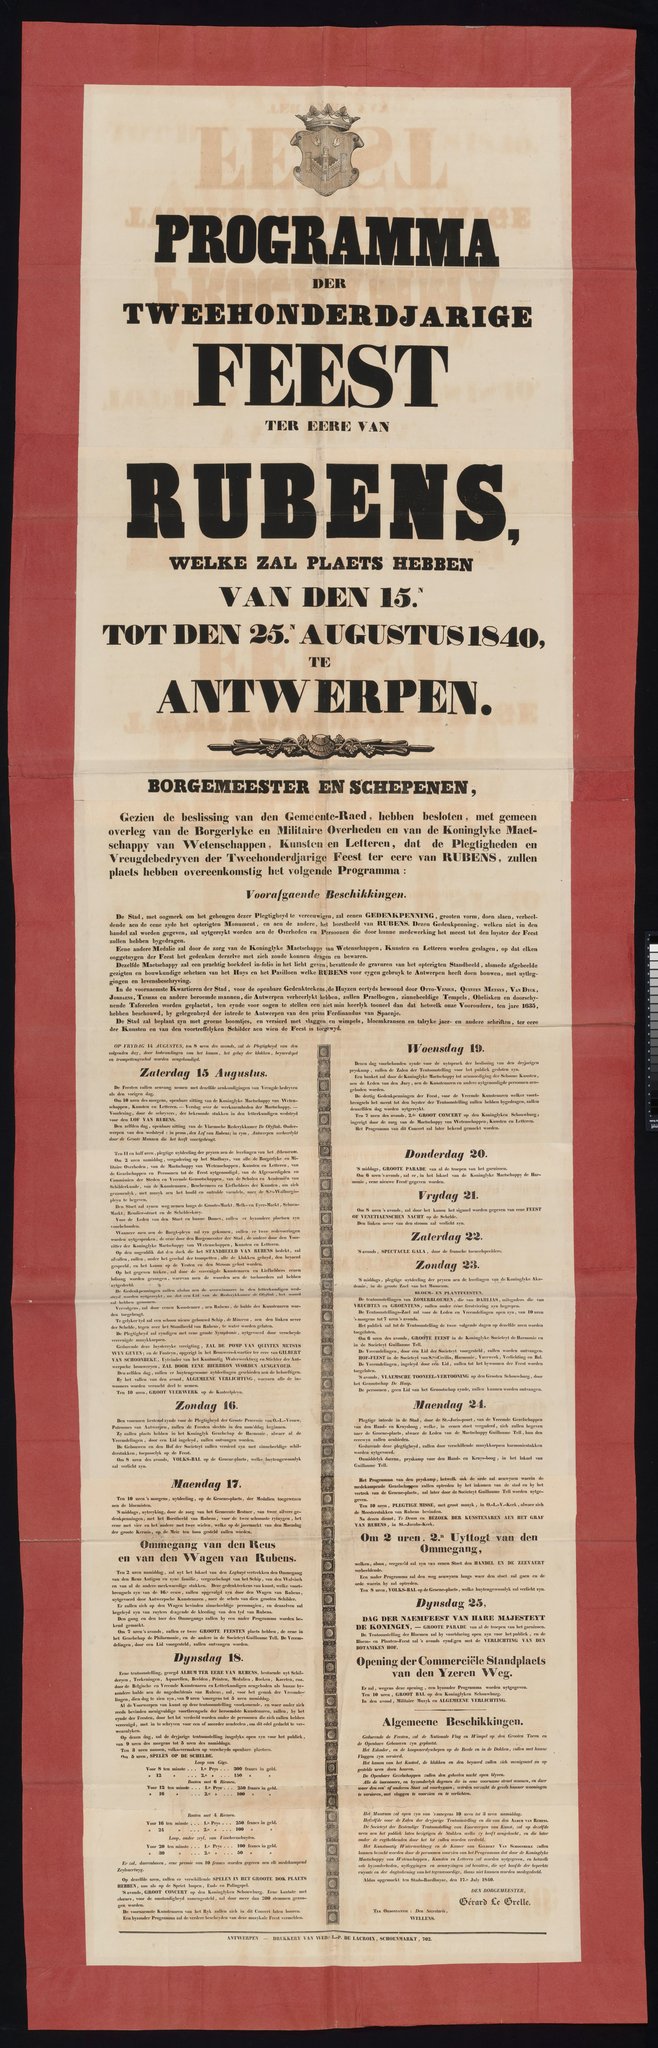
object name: poster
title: Programma der Tweehonderdjarige Feest ter eere van Rubens, welke zal plaets hebben van den 15.n tot den 25.n Augustus 1840, te Antwerpen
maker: weduwe l.-p. de lacroix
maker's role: printer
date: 1808-1840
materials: paper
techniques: letterpress printing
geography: antwerp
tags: antwerp, painter, print maker, draughtsman, peter paul rubens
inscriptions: collector's mark: Lugt 2233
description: Affiche met de bekendmaking van het programma van de feestelijkheden te Antwerpen op 15-25 augustus 1840, ter gelegenheid van de herdenking van de tweehonderdste sterfdag van Peter Paul Rubens. Bovenaan het stadswapen van Antwerpen, onderaan het programma in twee kolommen. De randen verstevigd met rood papier.